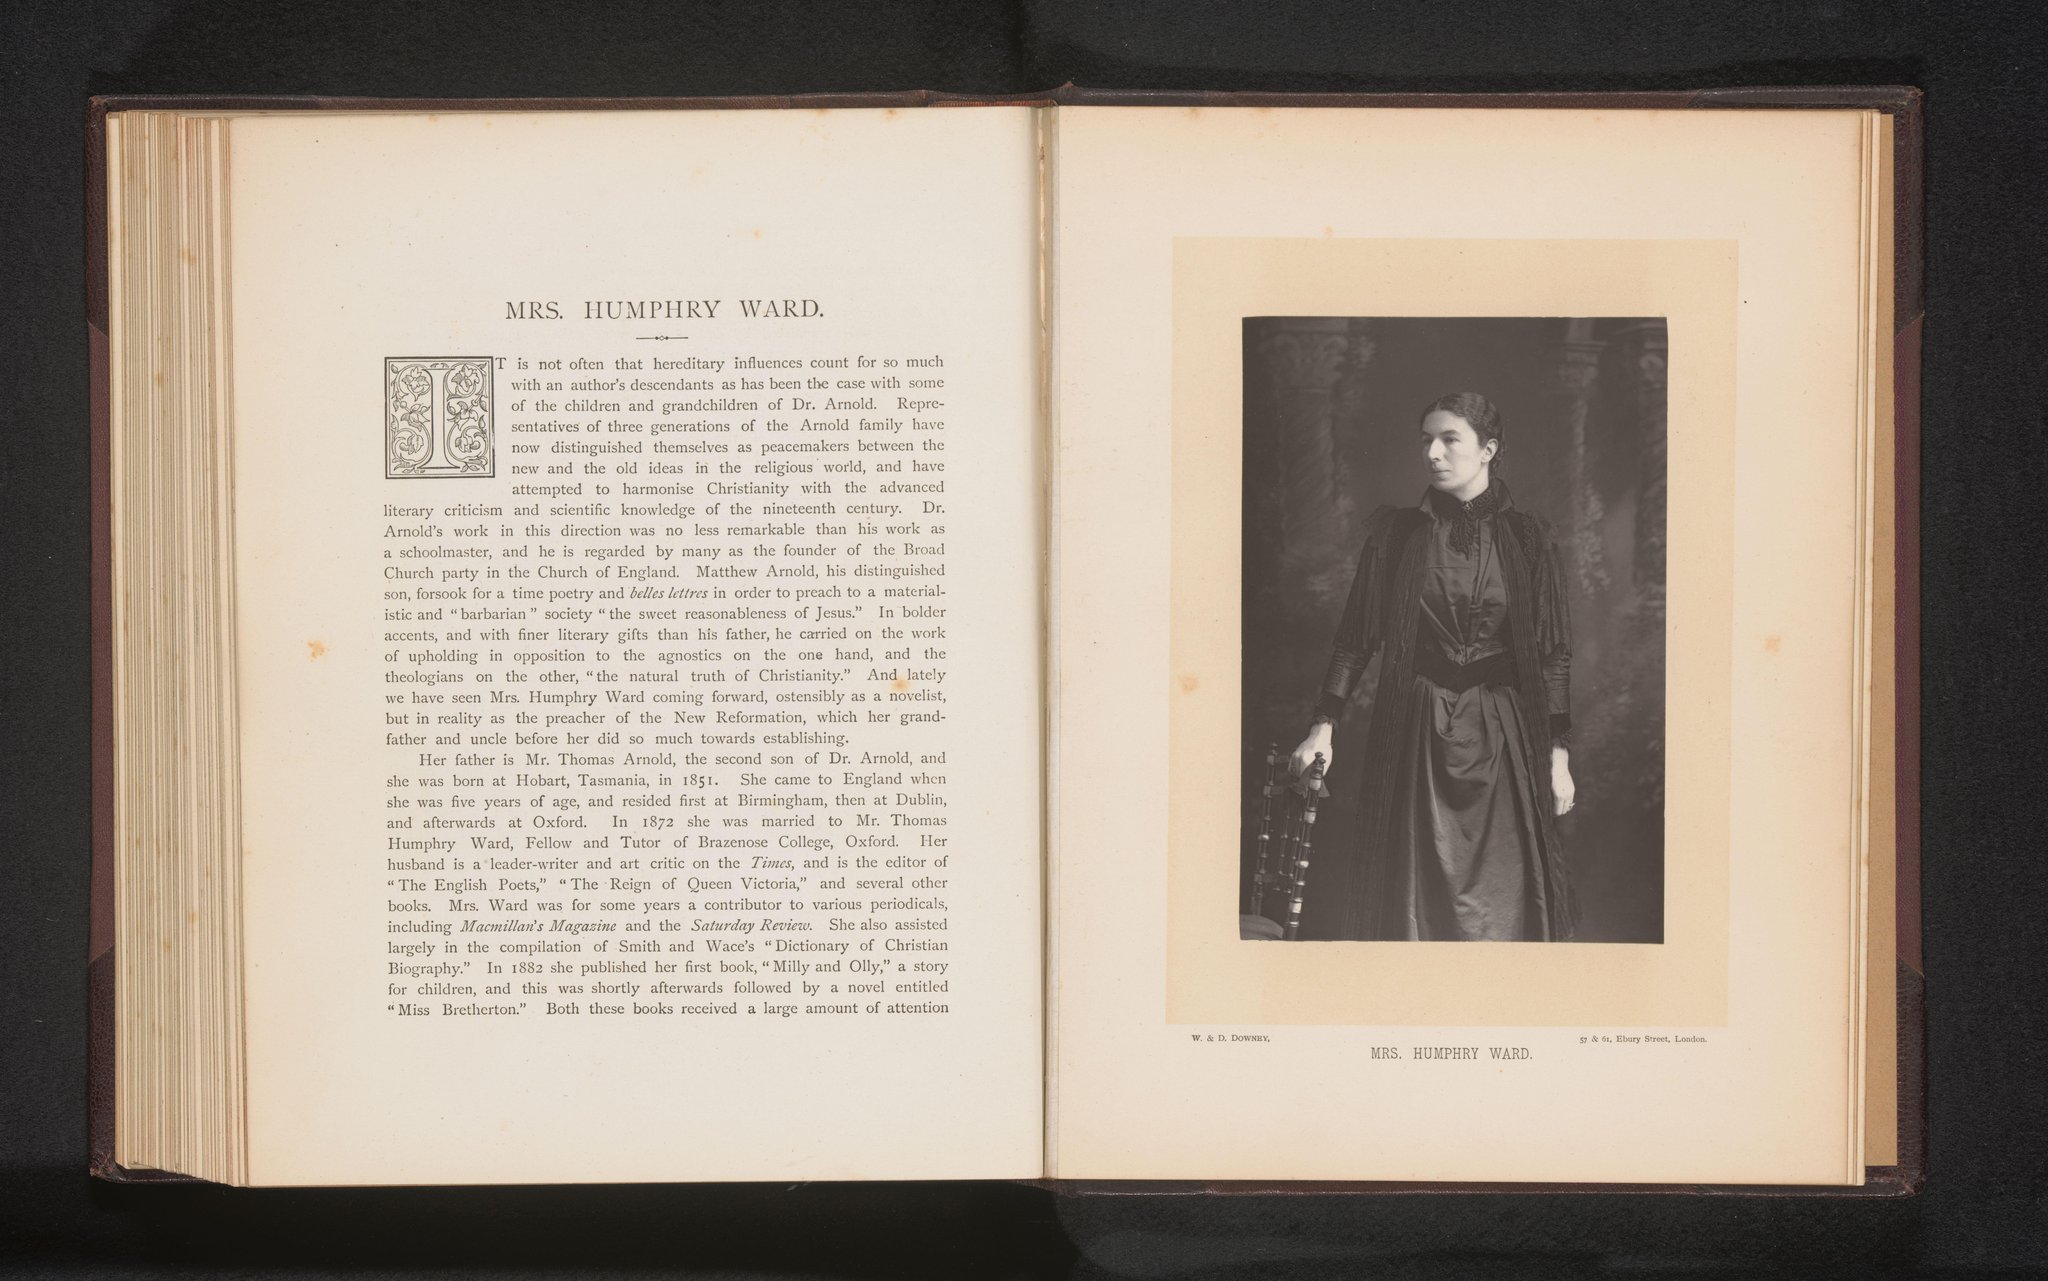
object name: photograph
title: Mrs. Humphry Ward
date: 1885-1890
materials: paper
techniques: carbon print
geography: london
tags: london, historical persons - bb - woman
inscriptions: address: ‘57 & 61, Ebury Street, London.’